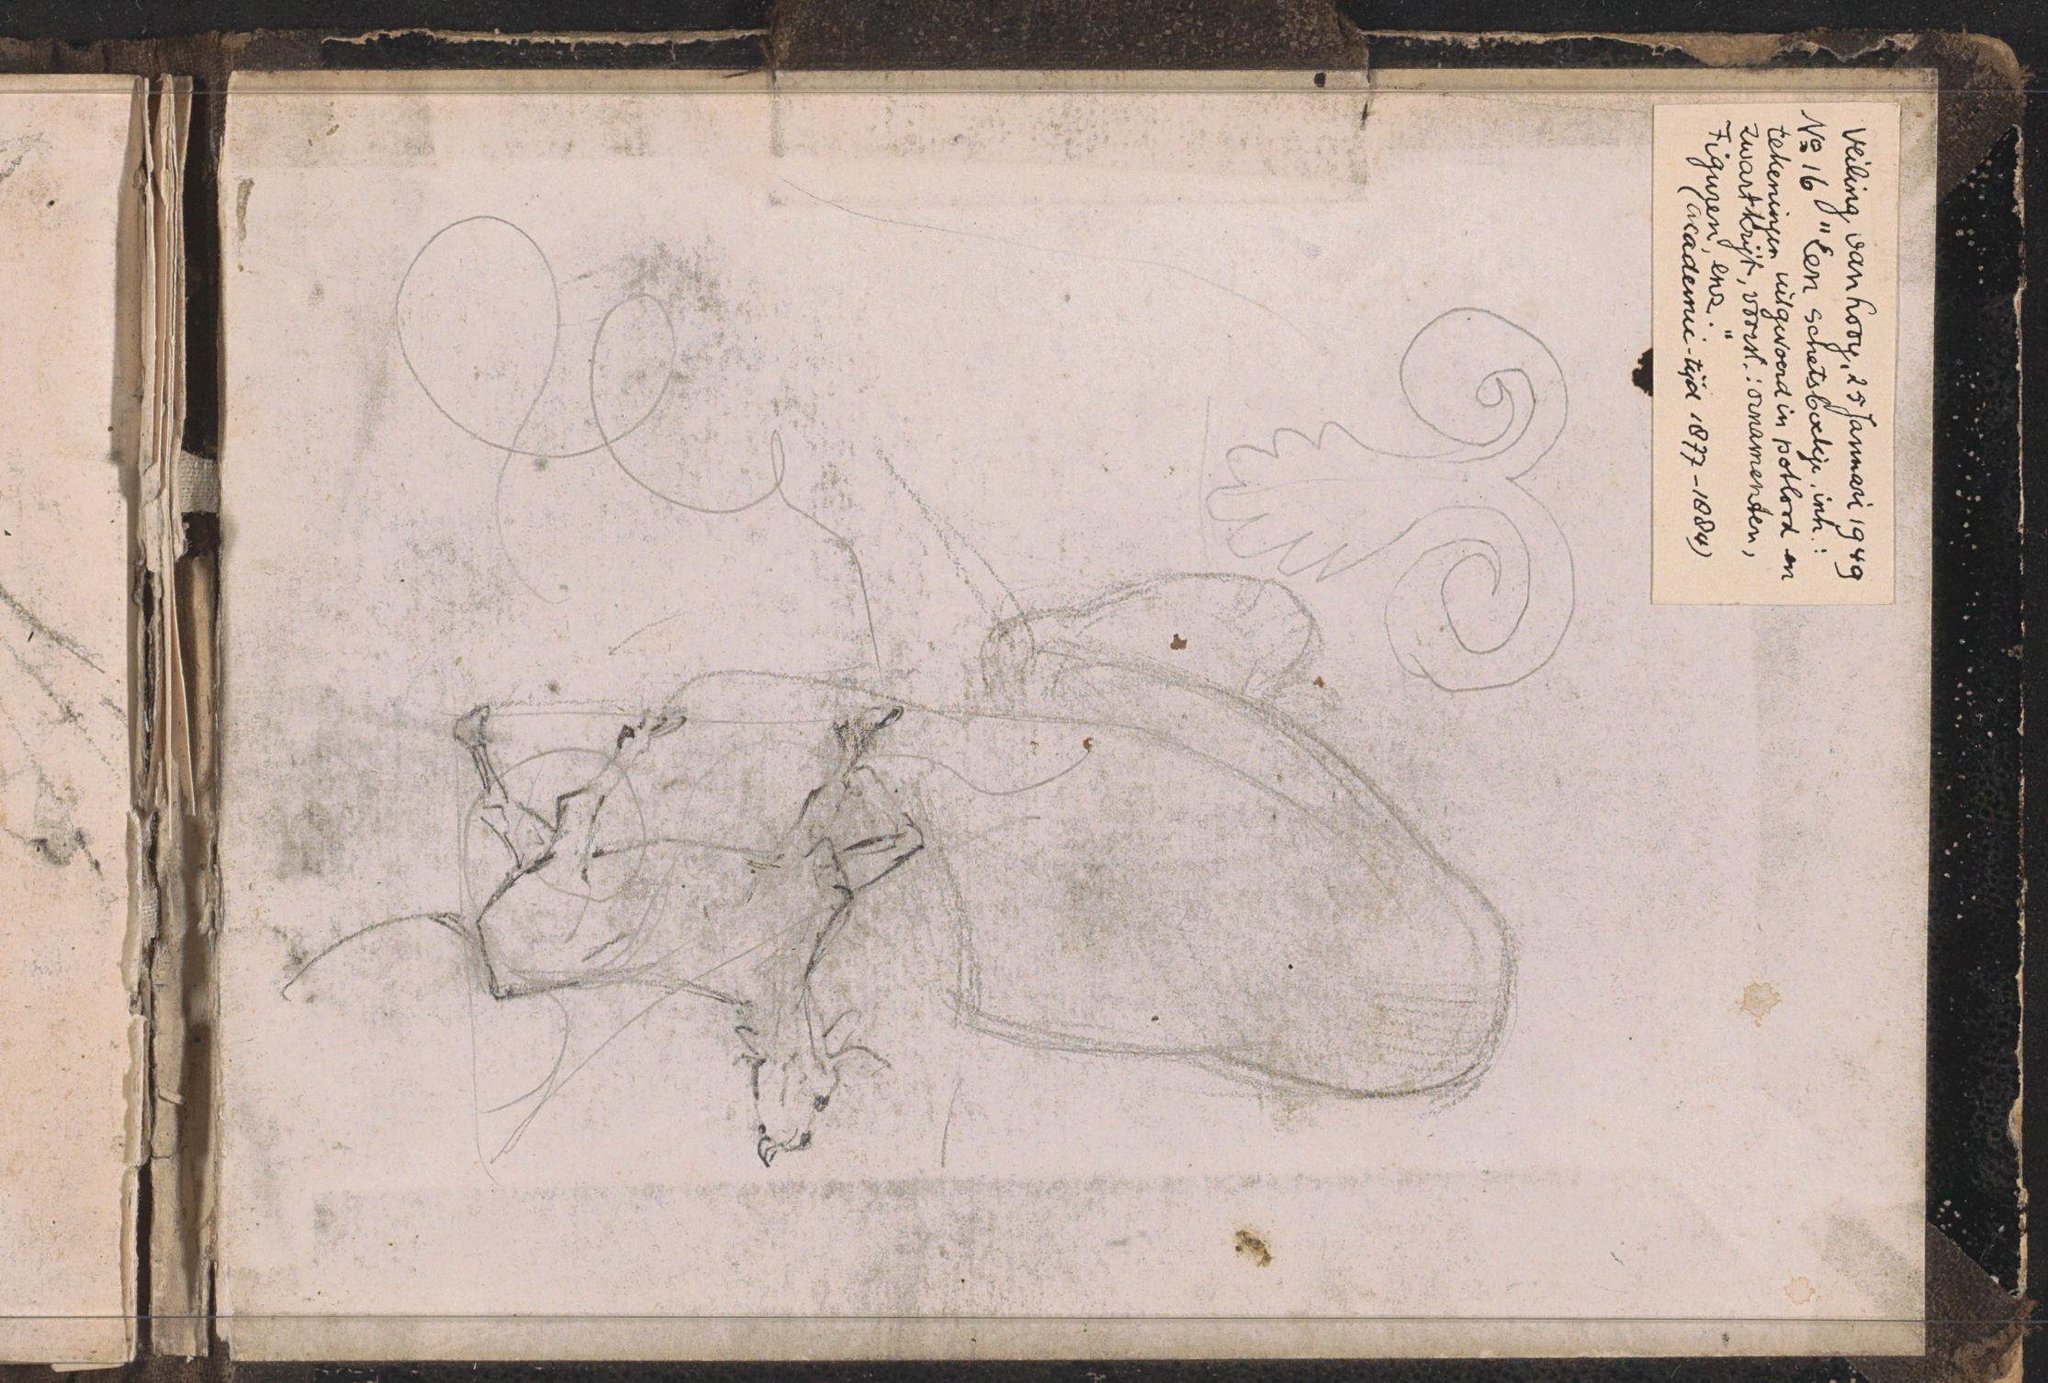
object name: sketchbook leaf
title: Koe en een ornament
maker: jac van looij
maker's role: draughtsman, painter, print maker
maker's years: 1855-1930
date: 1877-1880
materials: paper, pencil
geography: amsterdam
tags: ornaments ~ art, cow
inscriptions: label: ‘veiling van Looy, 25 Januari 1949/ No 16 "Een schetsboekje, inh:/ tekeningen uitgevoerd in potlood en/ zwart krijt, voorst. ornamenten, / figuren enz."/ (academie-tijd 1877-1884)’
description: Blad 27 verso uit een schetsboek met 27 bladen.